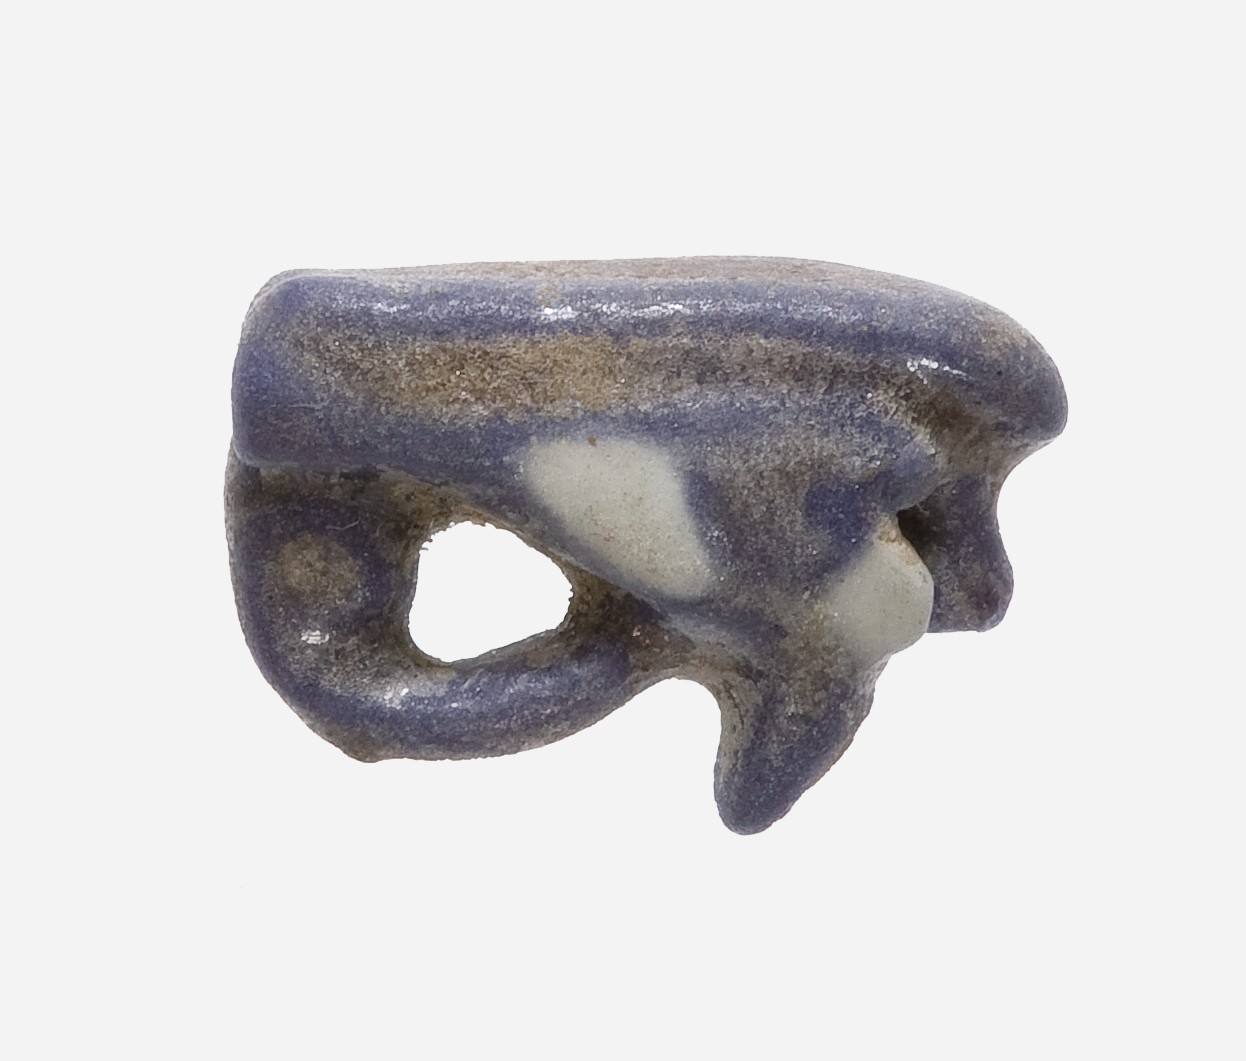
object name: amulet, wedjat eye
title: Wedjat Eye Amulet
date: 1390-1352 BCE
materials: faience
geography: egypt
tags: eyes